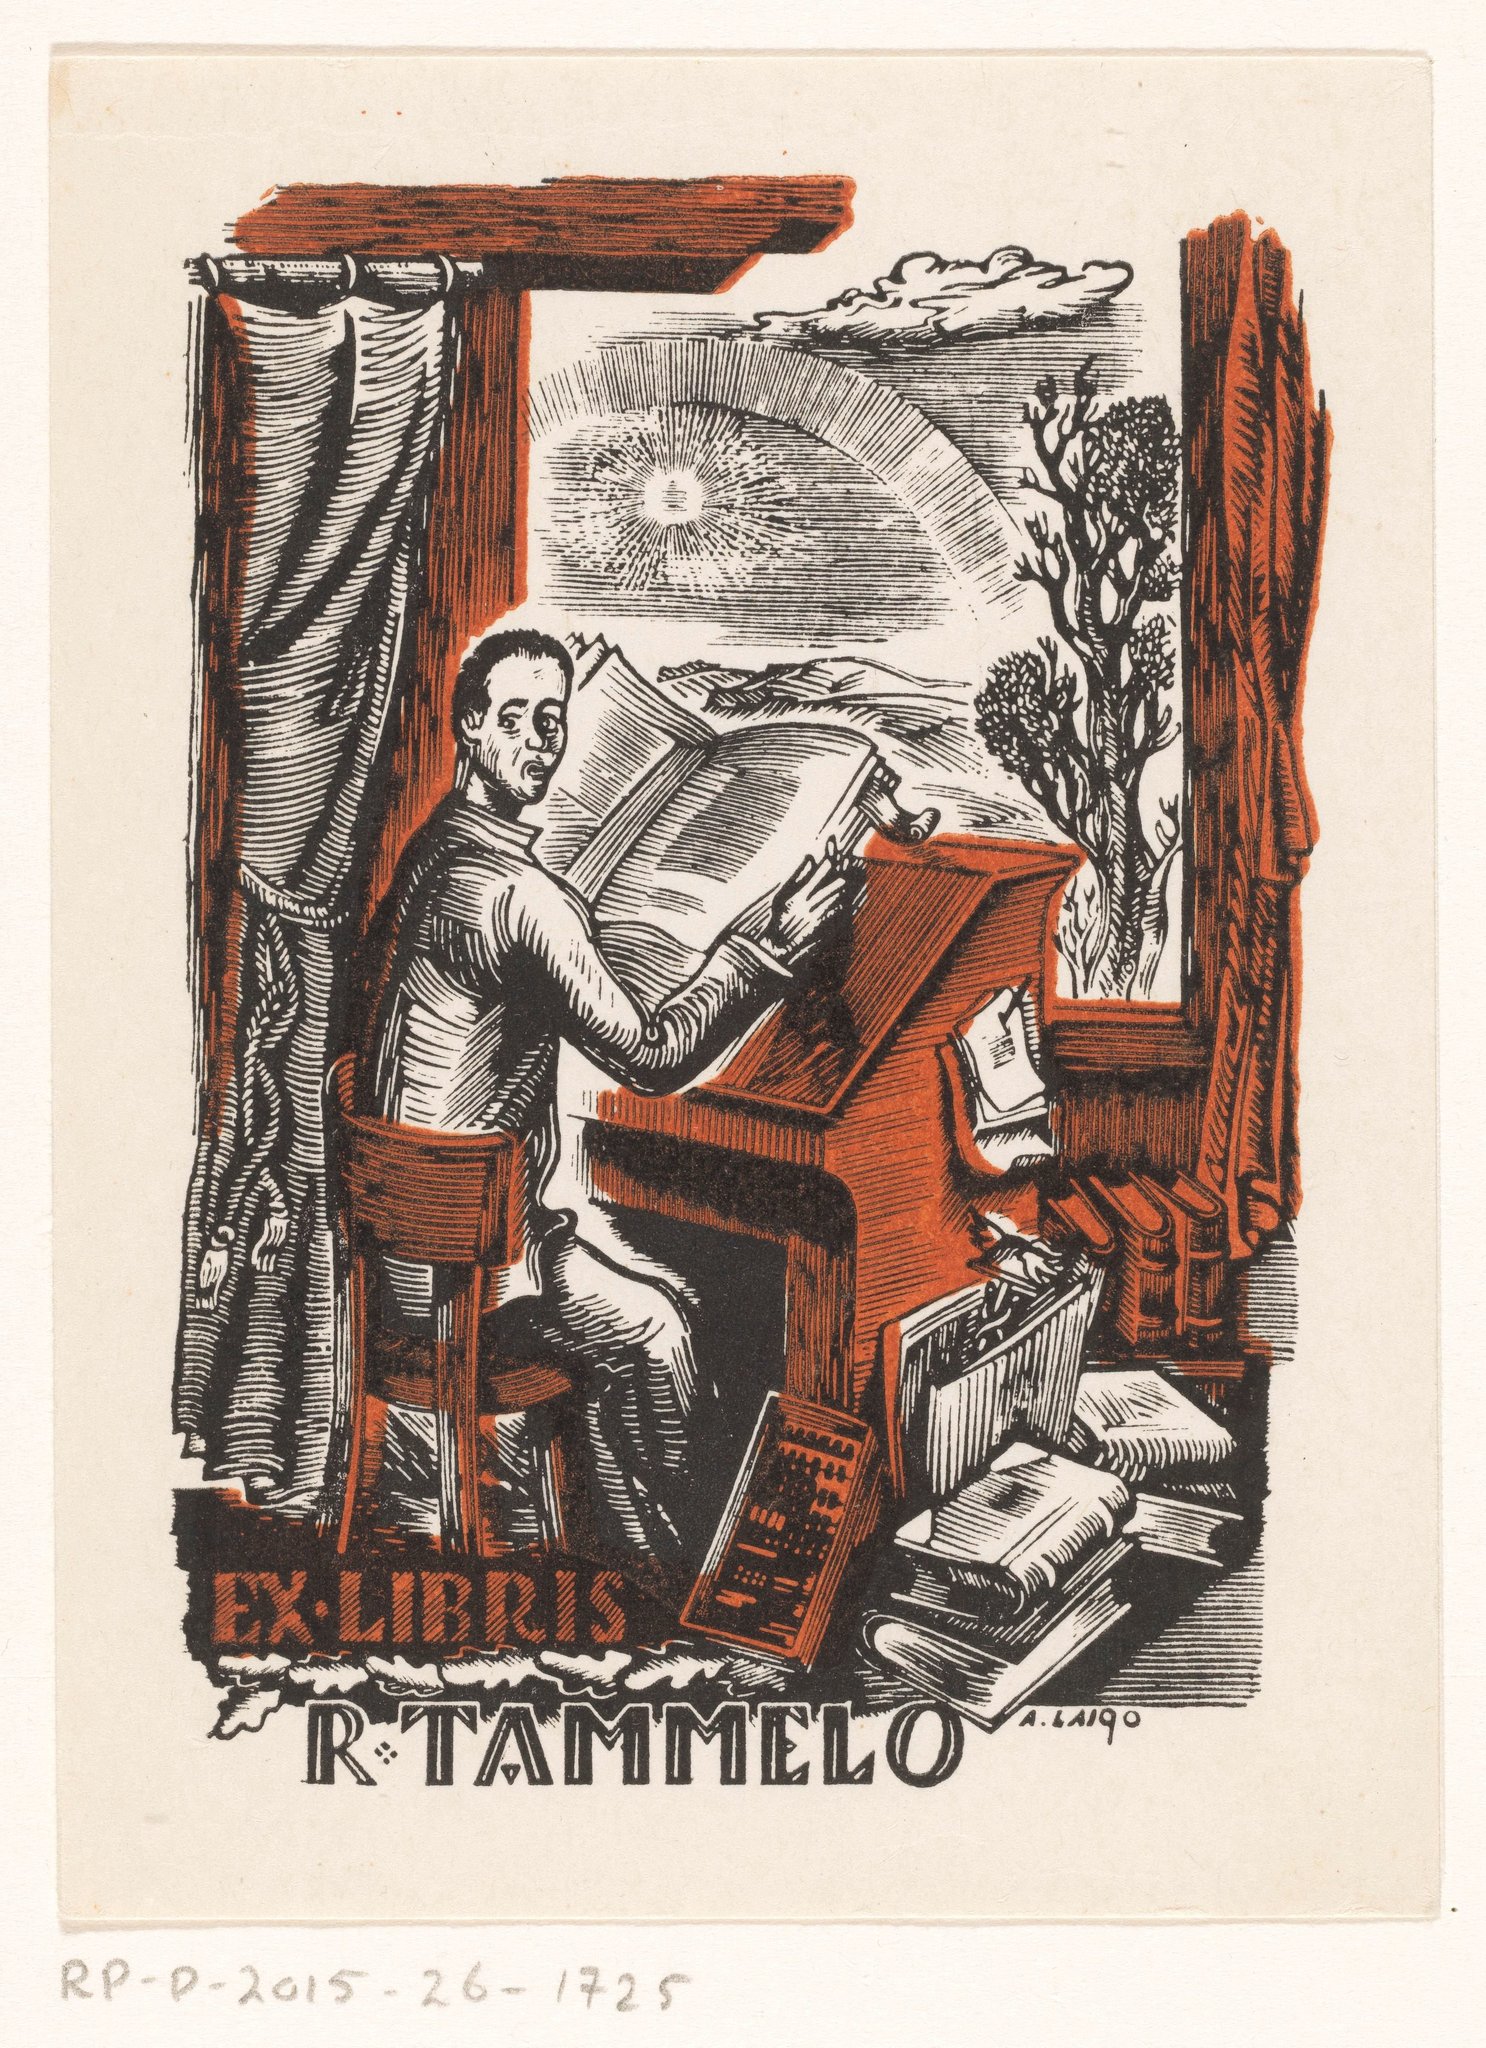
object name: print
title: Ex libris van R. Tammelo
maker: arkadio laigo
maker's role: print maker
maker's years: 1901-1944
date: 1942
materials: paper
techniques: wood engraving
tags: reading, study; 'studiolo'; library, book, rainbow, lectern ~ reading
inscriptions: stamp: ‘Arkadio Laigo Boix (X2) Estonien SSR’, collector's mark: Lugt 2228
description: Man lezend in een boek dat op een lessenaar in een studeervertrek staat. Op de grond liggen boeken. Door het raam is een landschap met een zon en een regenboog zichtbaar.